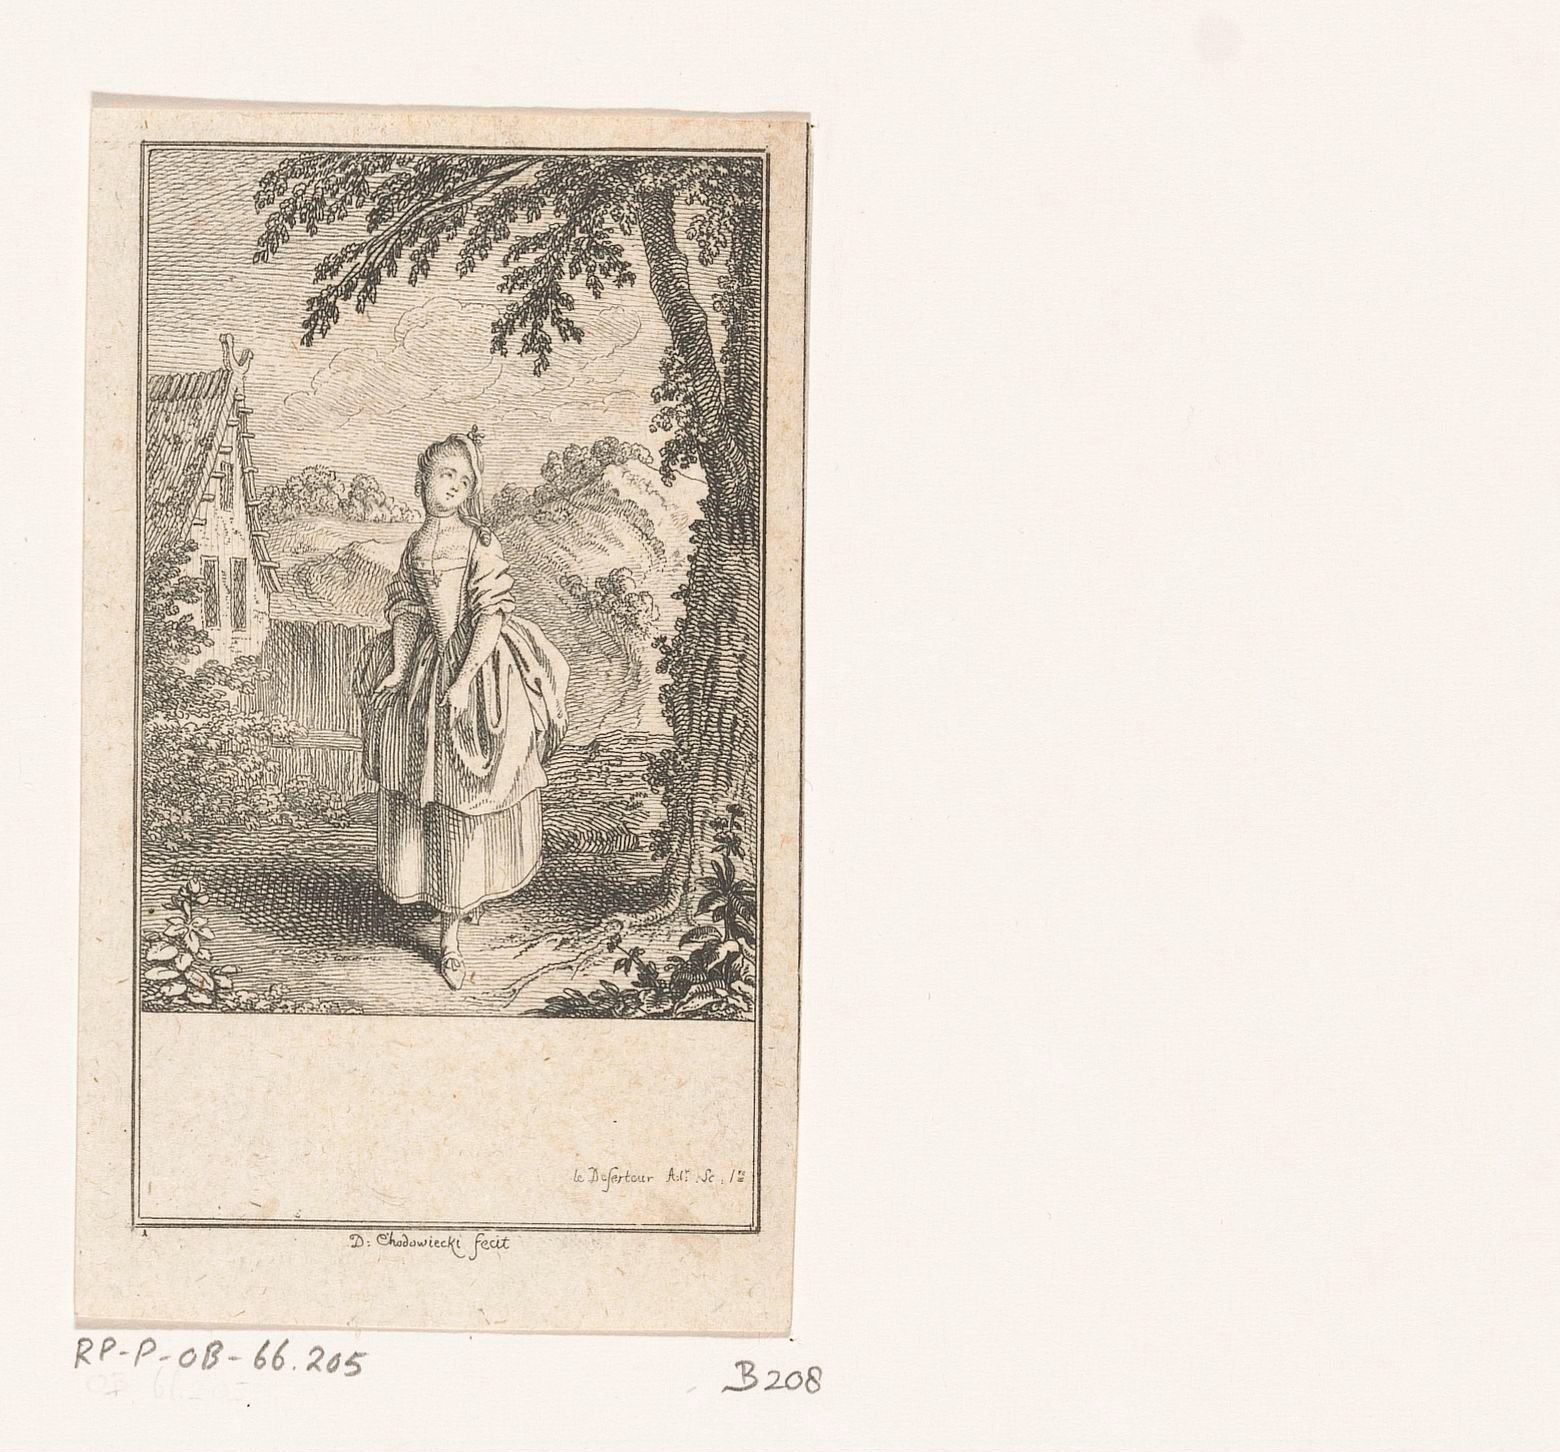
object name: print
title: Scène uit de Deserteur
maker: daniel nikolaus chodowiecki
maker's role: draughtsman, print maker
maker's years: 1726-1801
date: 1774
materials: paper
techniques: etching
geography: berlin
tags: paris, literature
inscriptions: collector's mark: Lugt 240, collector's mark: Lugt 700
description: Eerste scène uit een serie van twaalf scènes die de opéra comique 'Le déserteur' door Michel-Jean Sedaine illustreren. De scènes werden op een plaat geëtst. De tweede staat van deze serie werd ook gebruikt in: 'Berliner genealogischen Calender auf das Jahr 1775'.